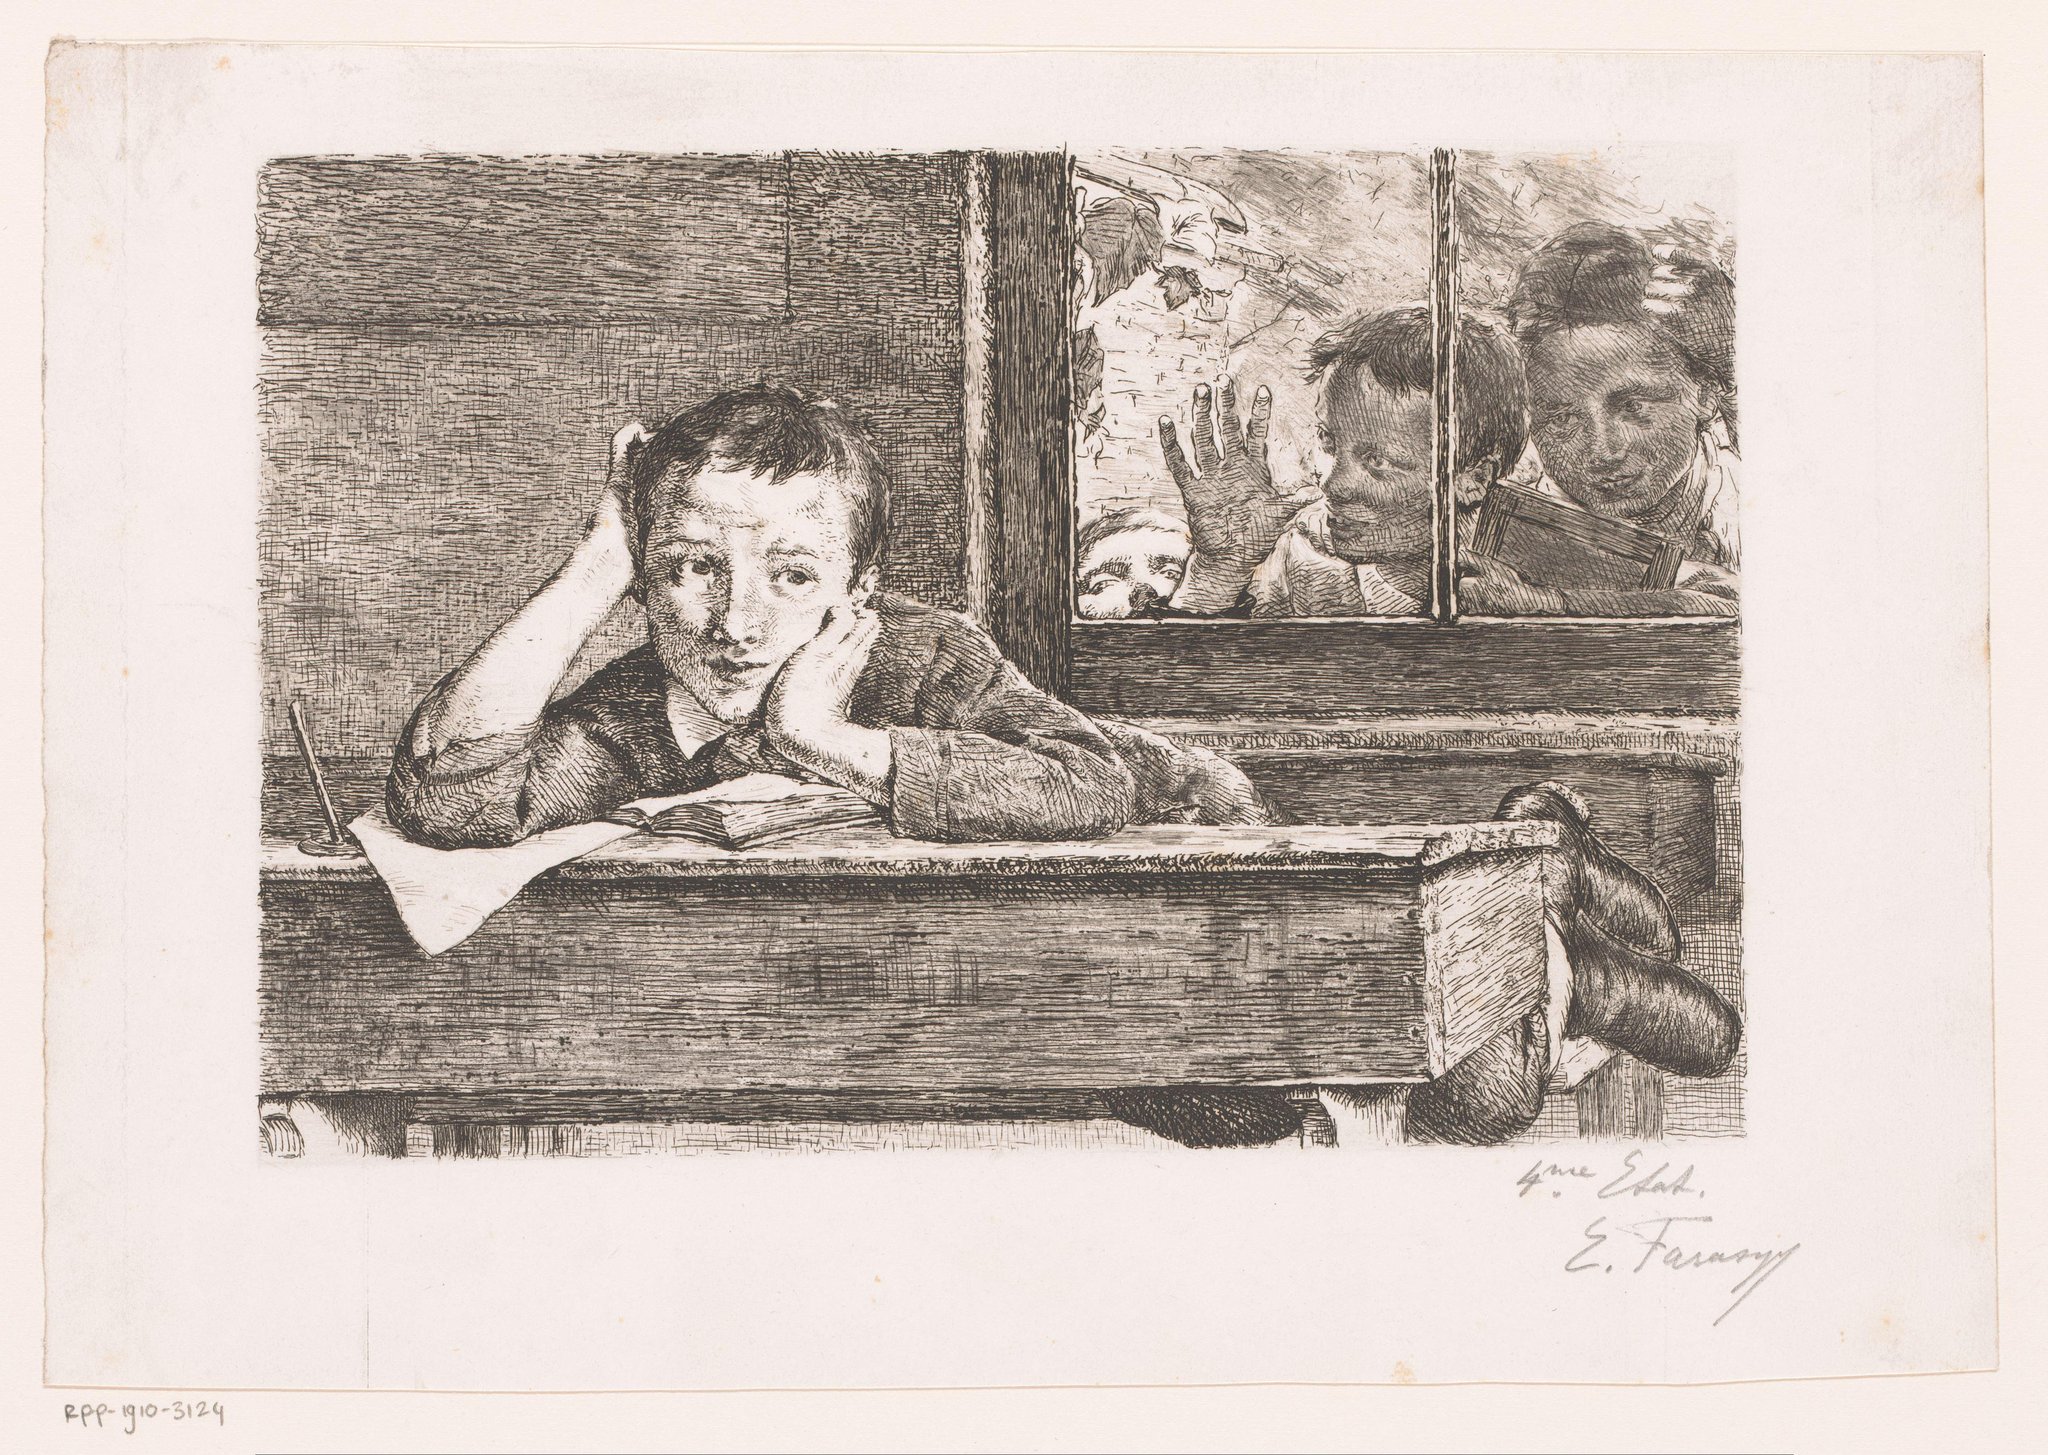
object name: print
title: Drie kinderen kijken door een raam naar een jongen die over een schoolbank hangt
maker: edgard farasyn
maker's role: print maker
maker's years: 1858-1938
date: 1868-1910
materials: paper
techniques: etching, intaglio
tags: writing-table, writing-desk, child (+ four persons), closed window, elementary school; class, form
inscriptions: inscription: ‘4me Etat’, collector's mark: Lugt 2228